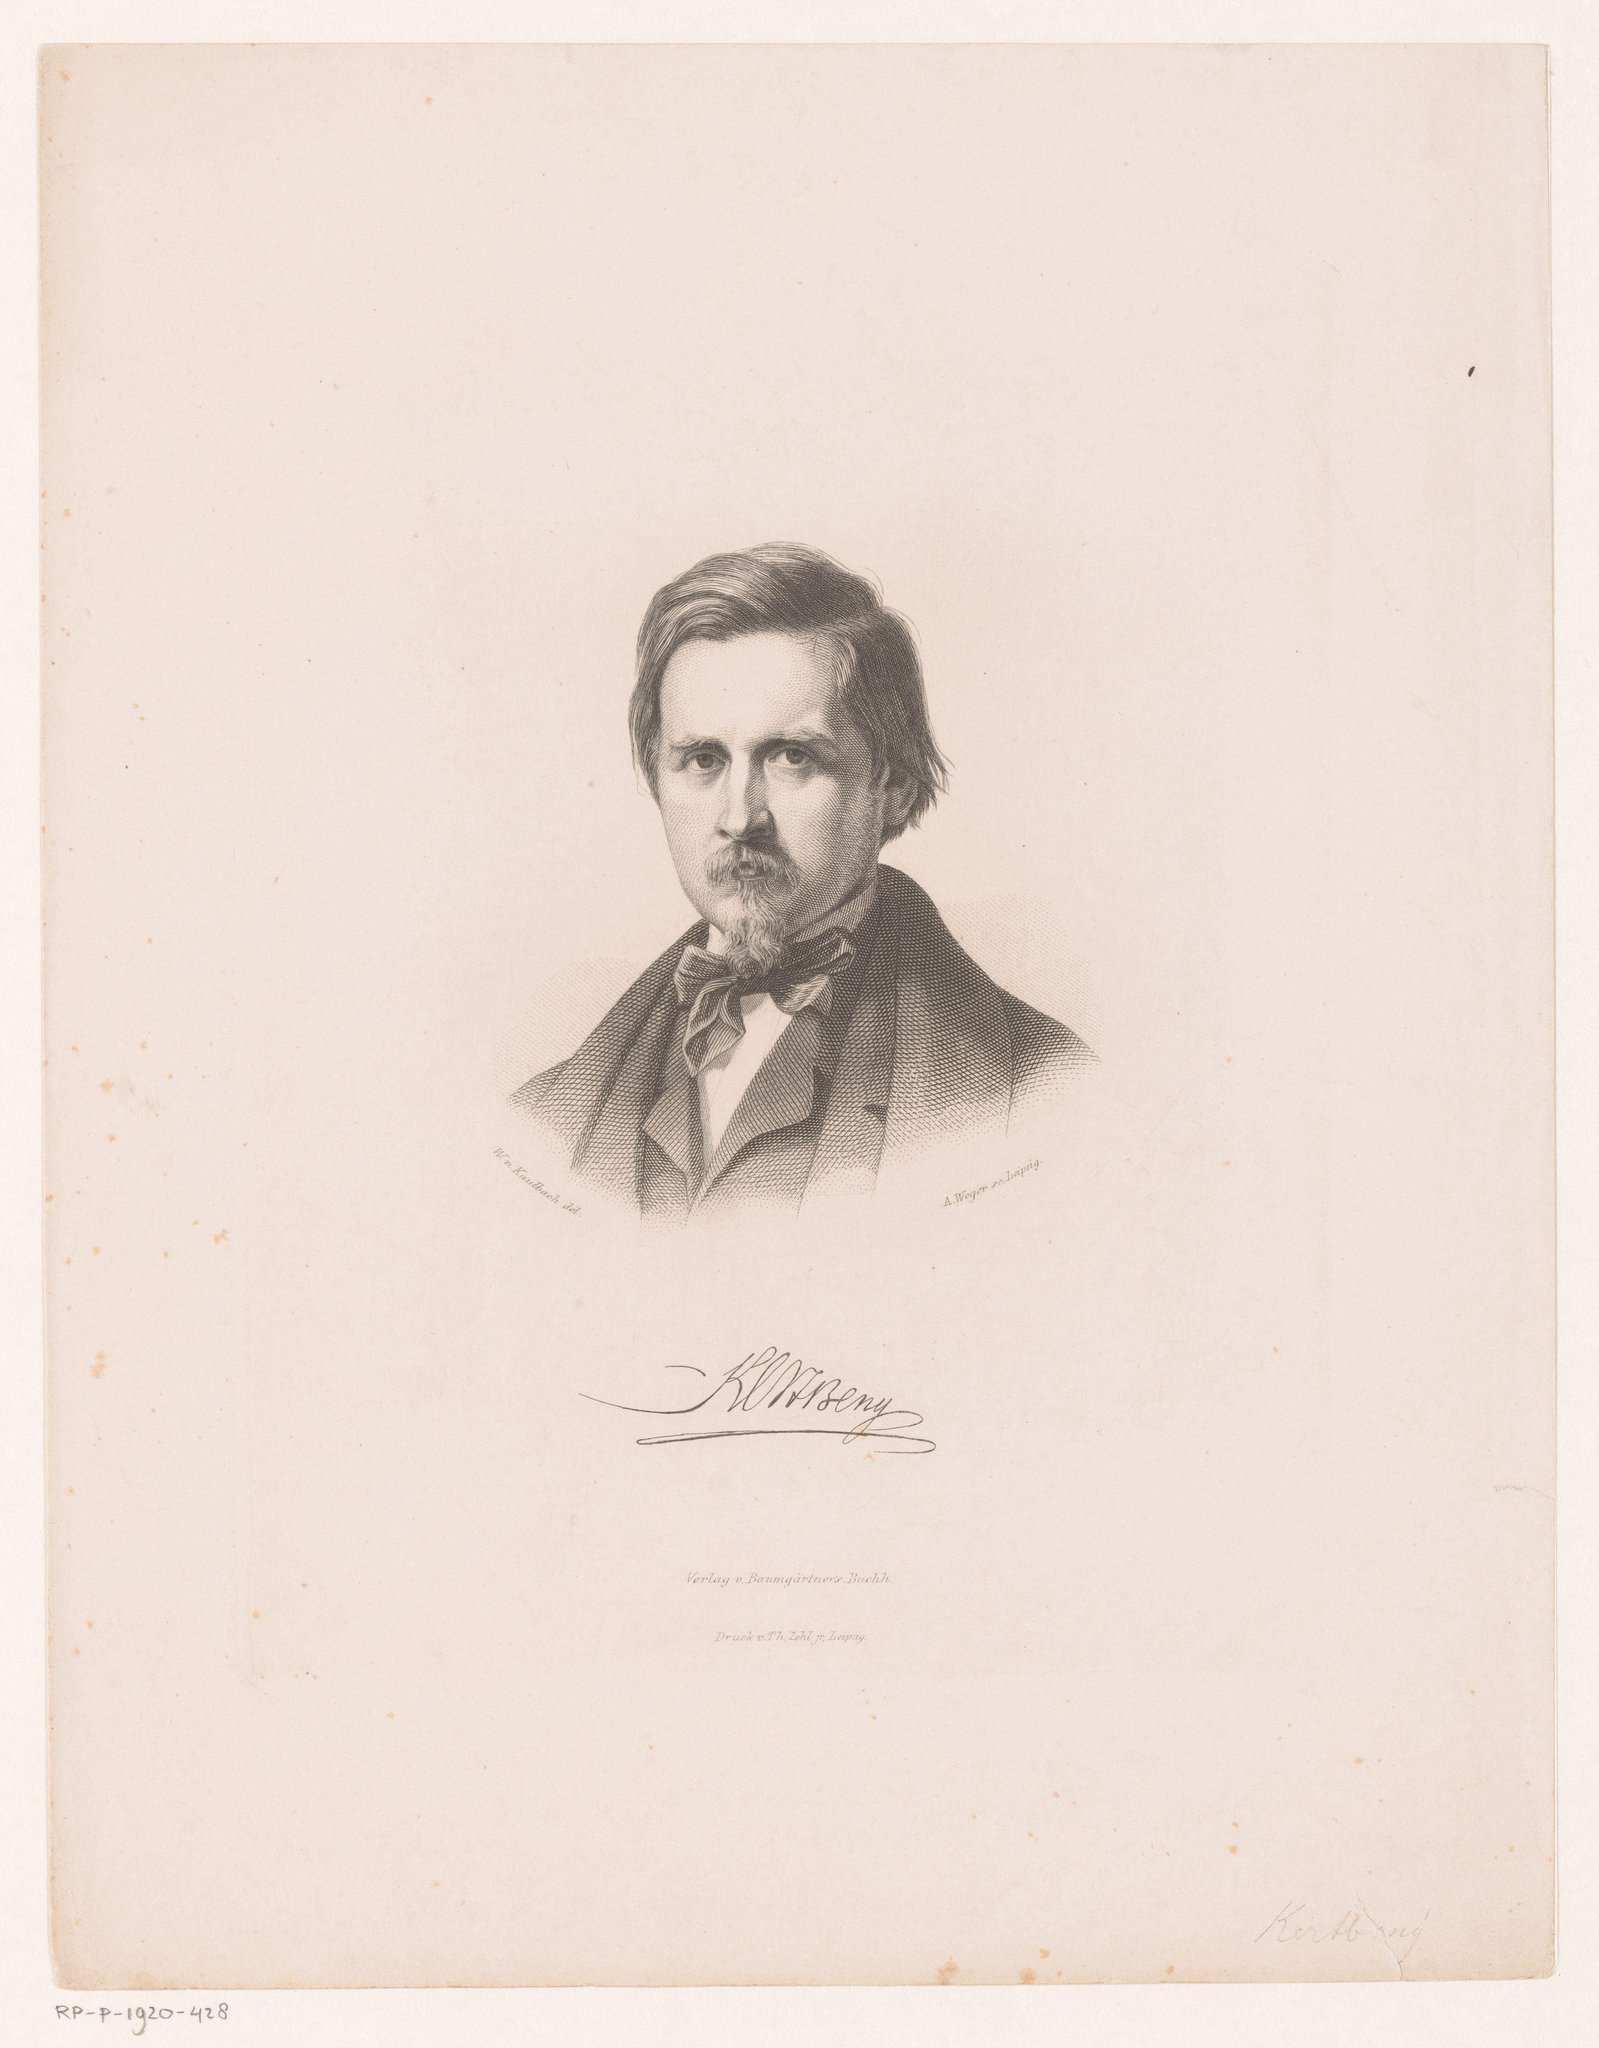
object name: print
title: Portret van Karl Maria Kertbeny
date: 1855-1892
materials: paper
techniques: engraving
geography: leipzig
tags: historical persons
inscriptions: collector's mark: Lugt 2228